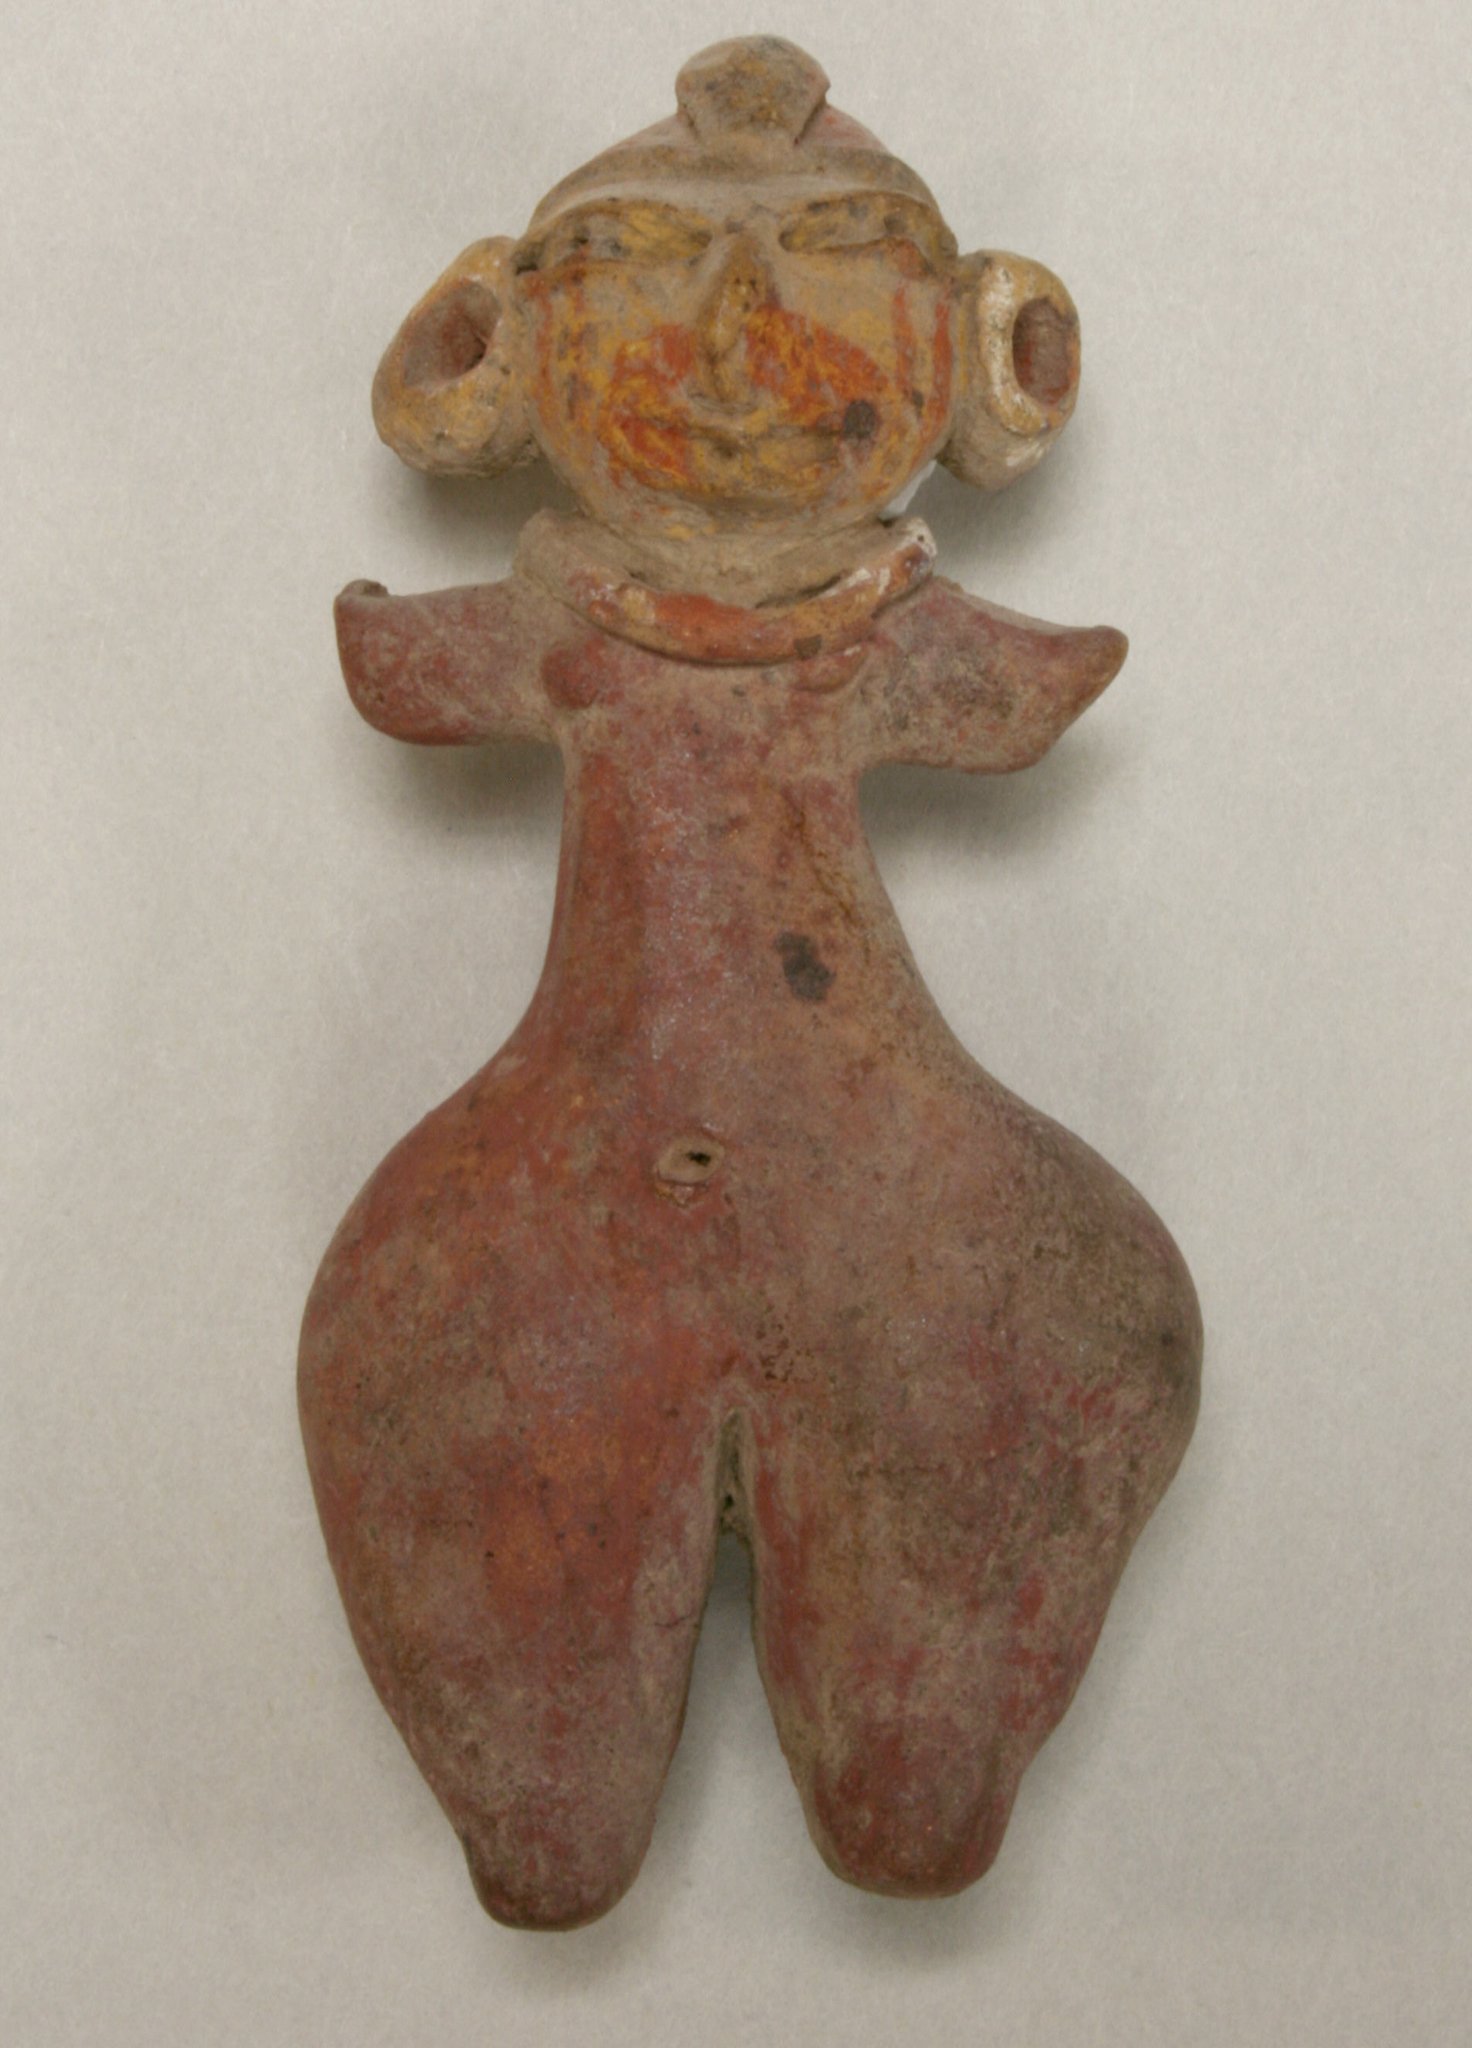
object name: female figure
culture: tlatilco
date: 1000-901 BCE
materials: ceramic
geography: mexico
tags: women